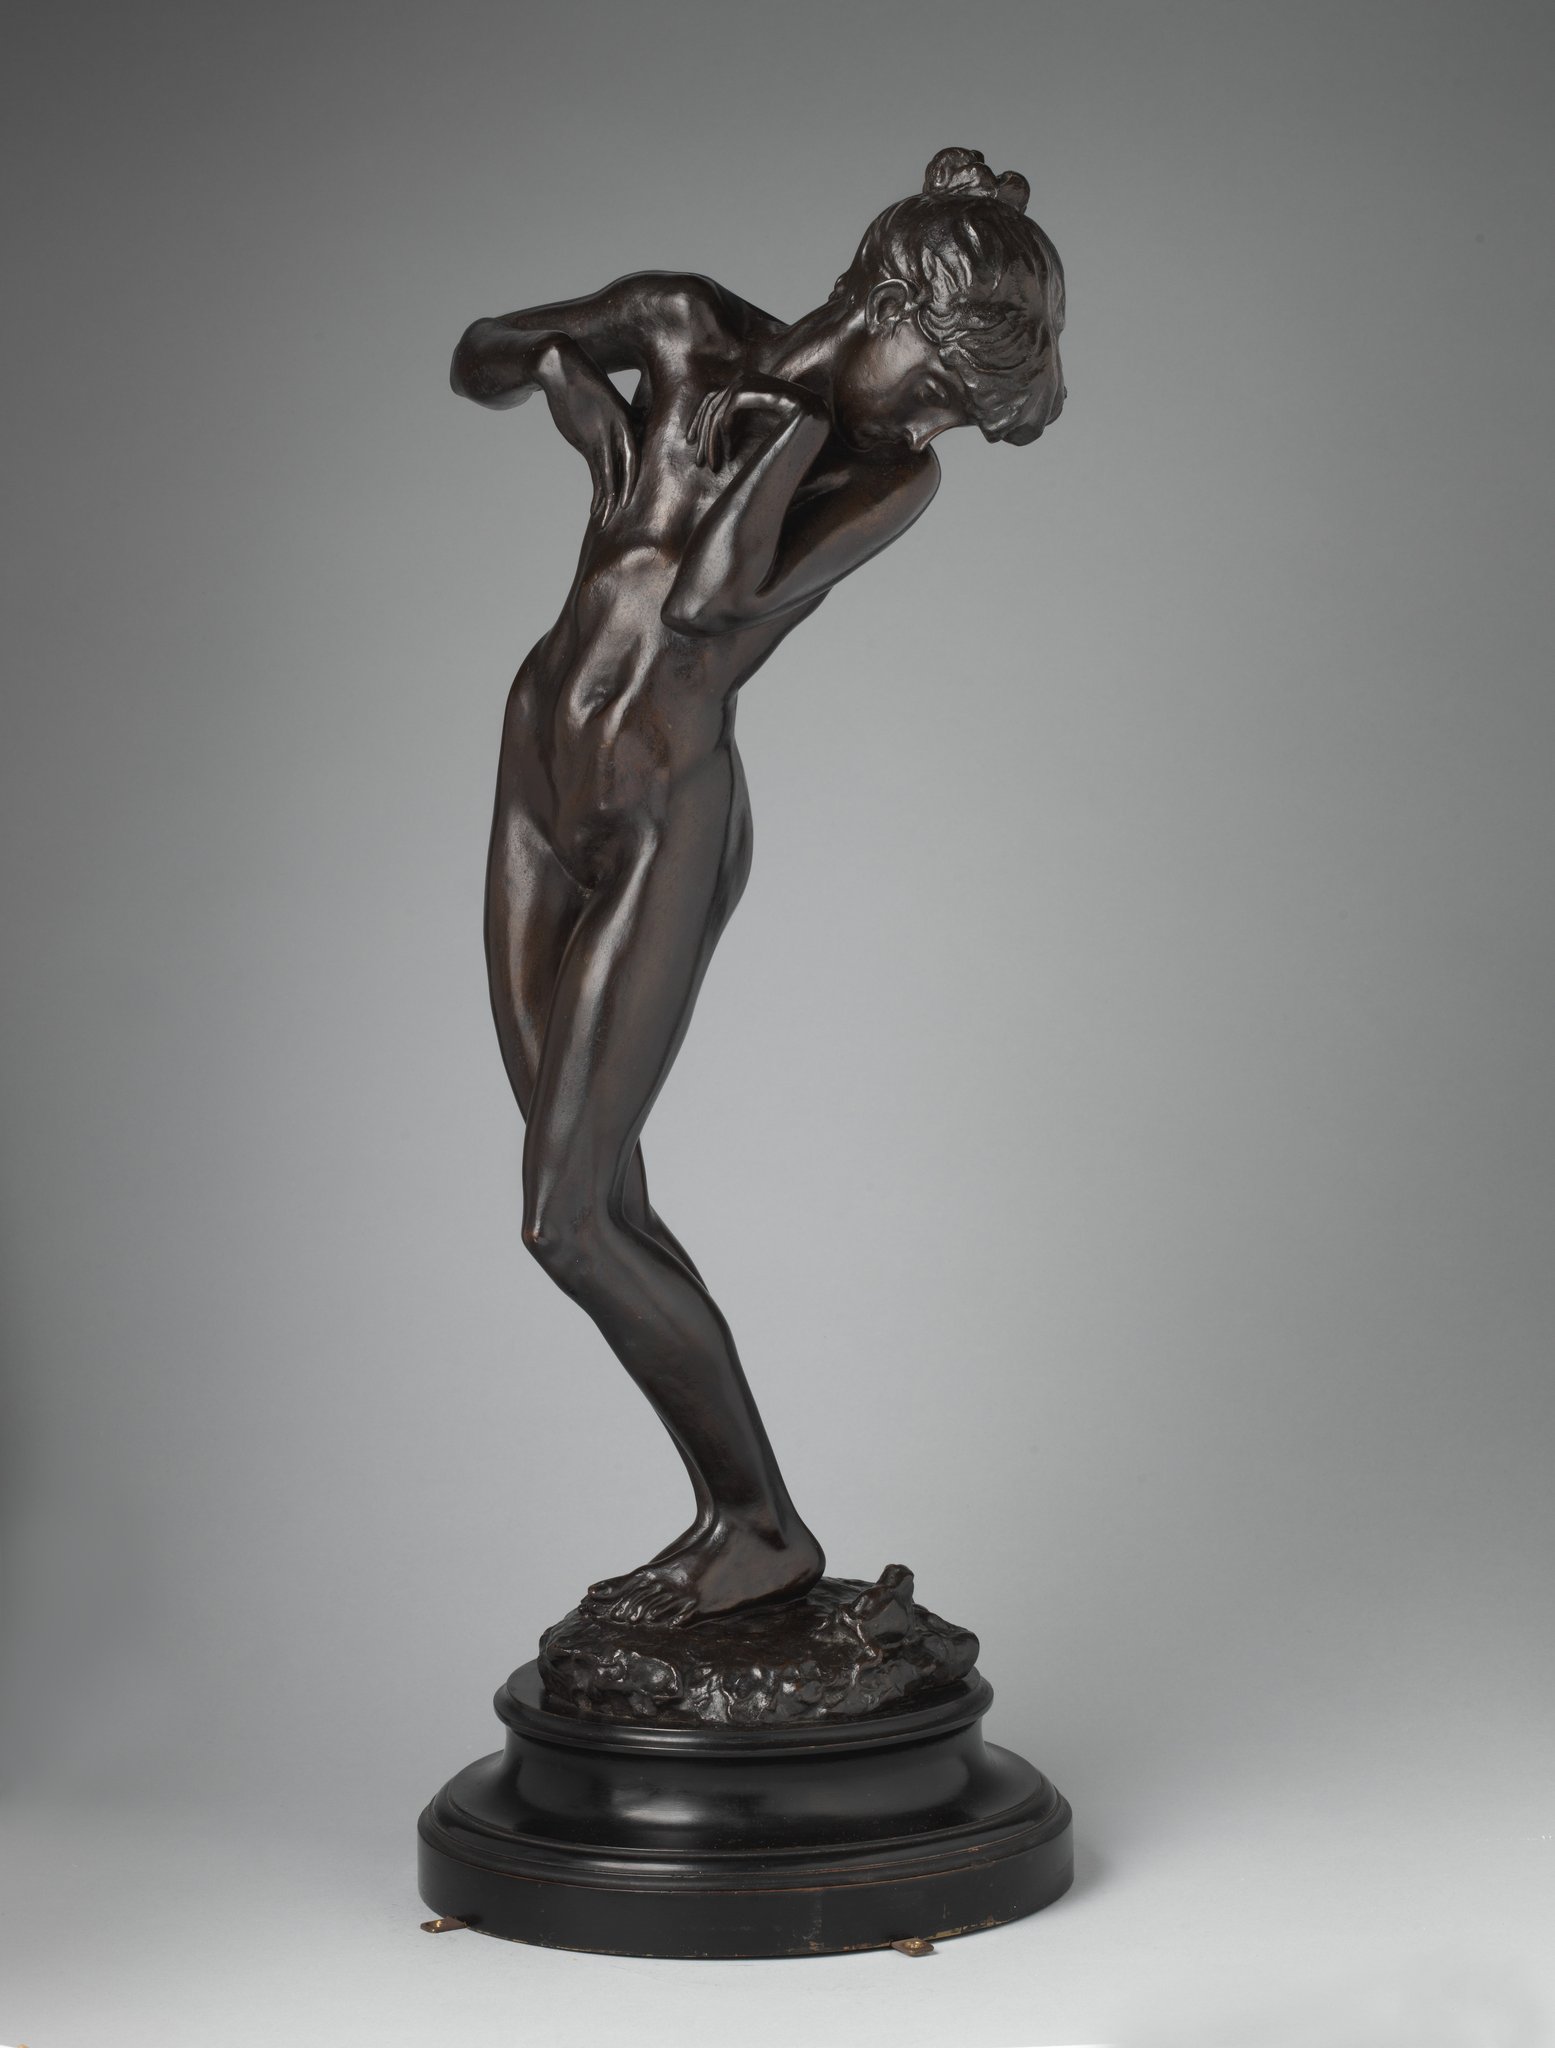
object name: statuette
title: Needless Alarms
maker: frederic, lord leighton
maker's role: artist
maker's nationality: british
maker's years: 1830-1896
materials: bronze, patina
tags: female nudes